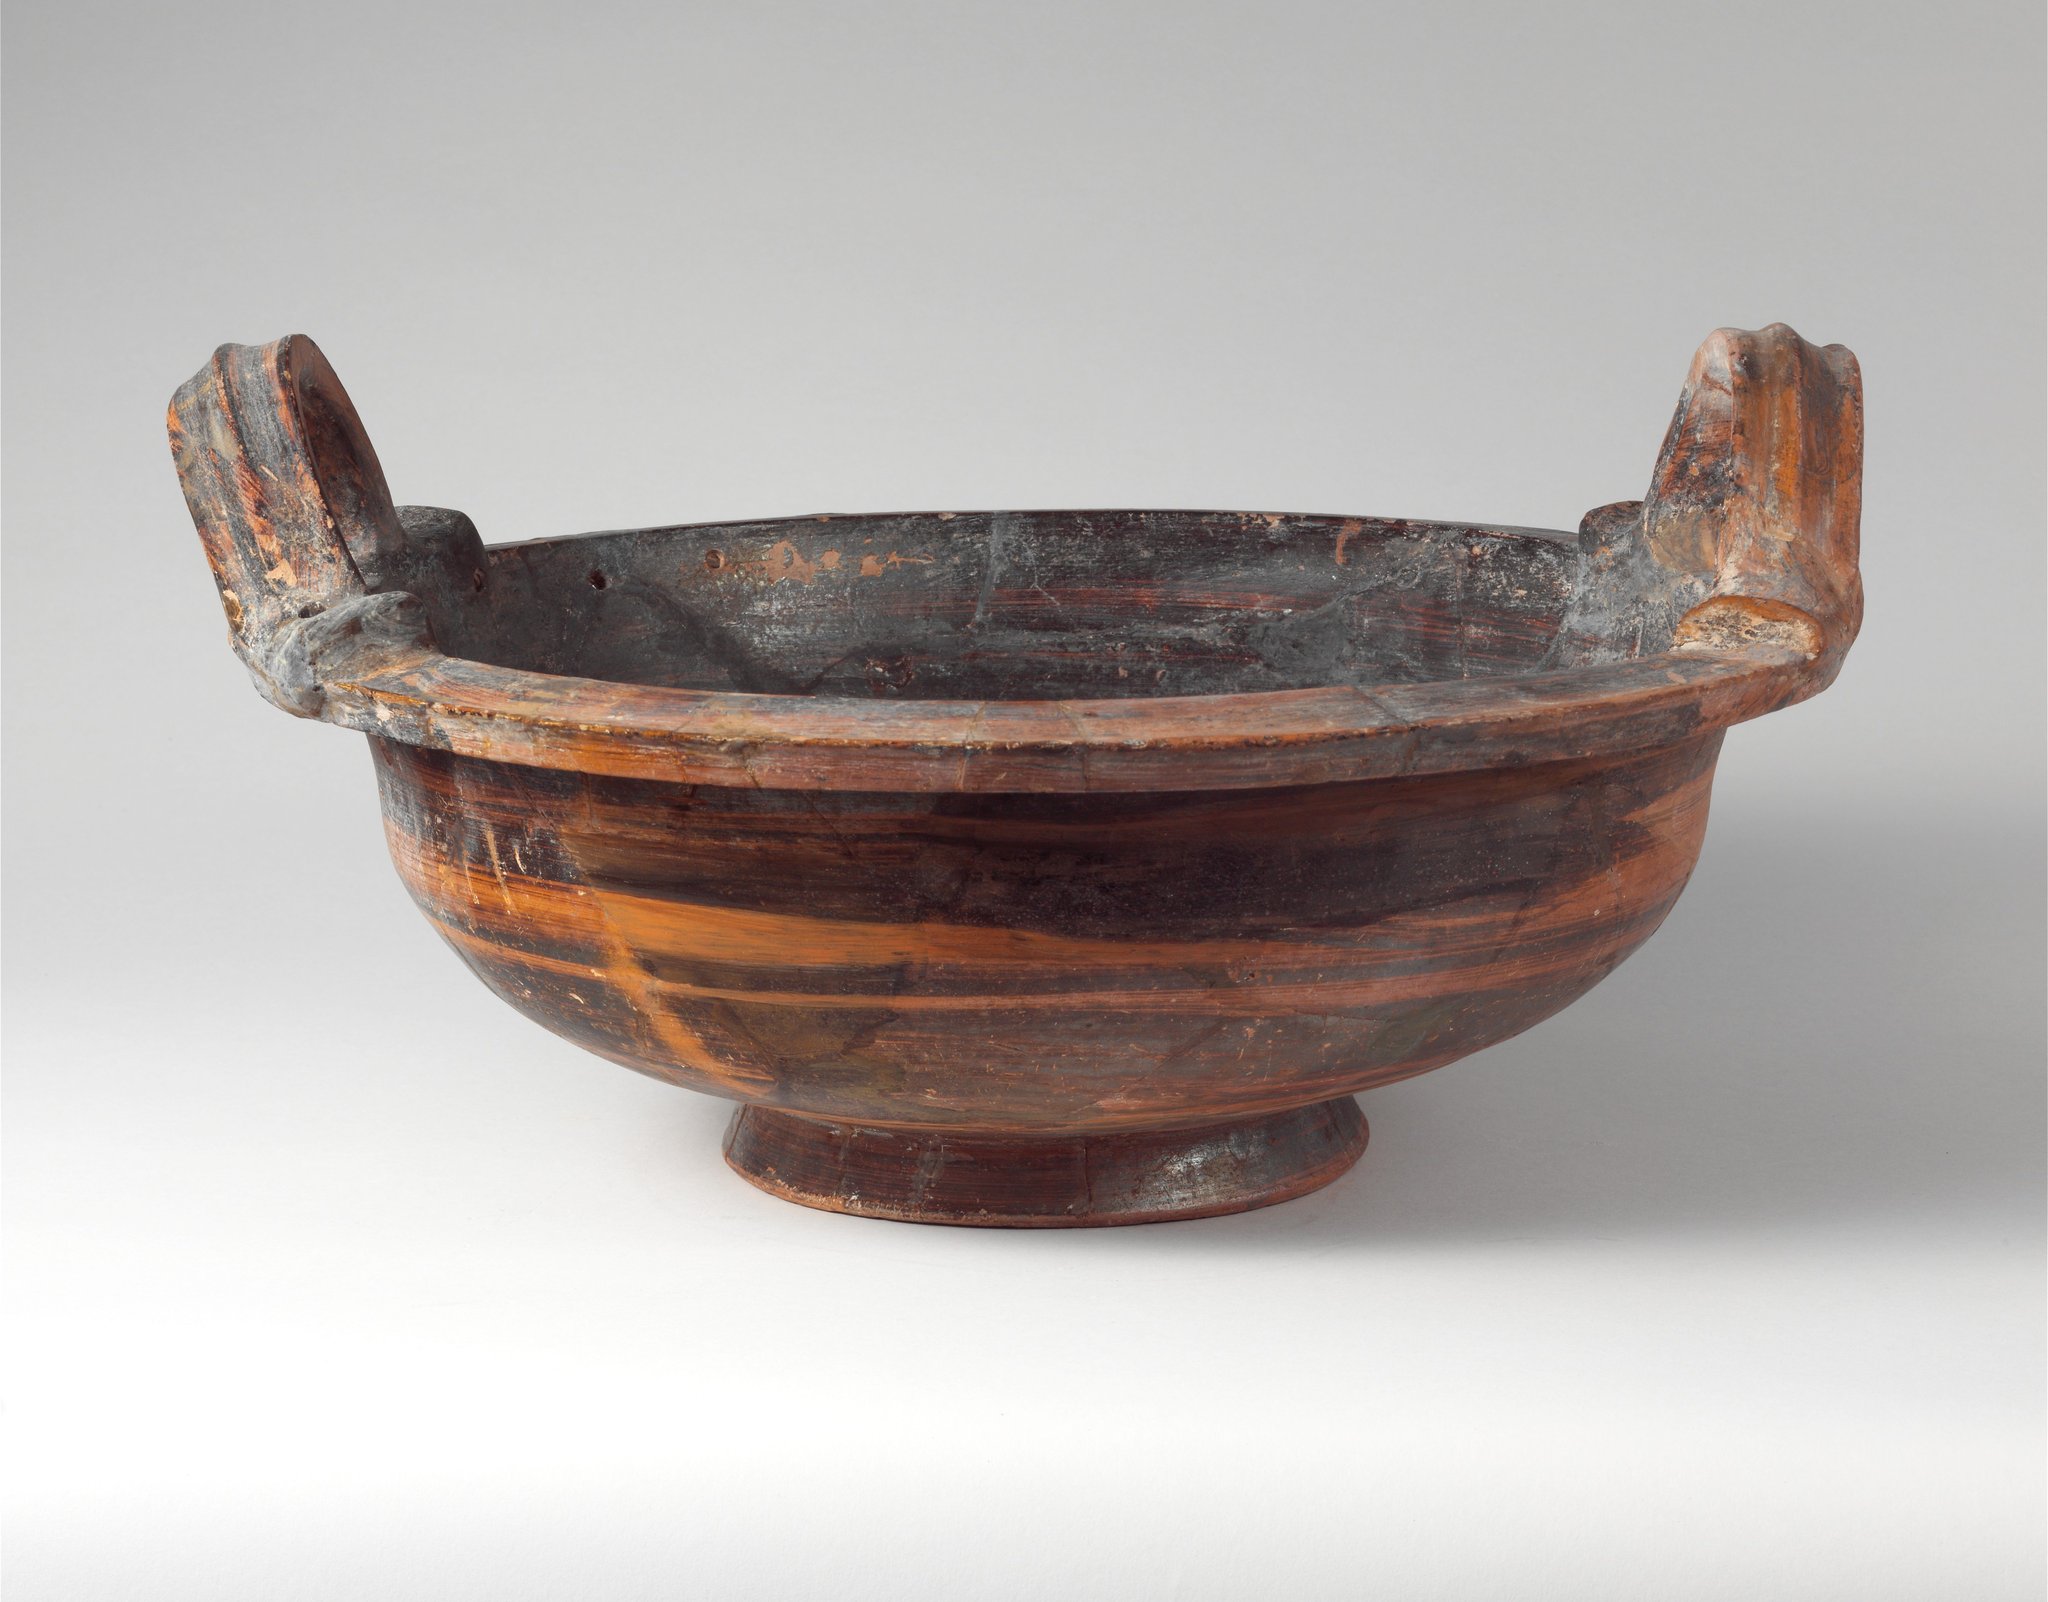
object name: bowl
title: Terracotta deep bowl with vertical handles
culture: lydian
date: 600-501 BCE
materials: terracotta